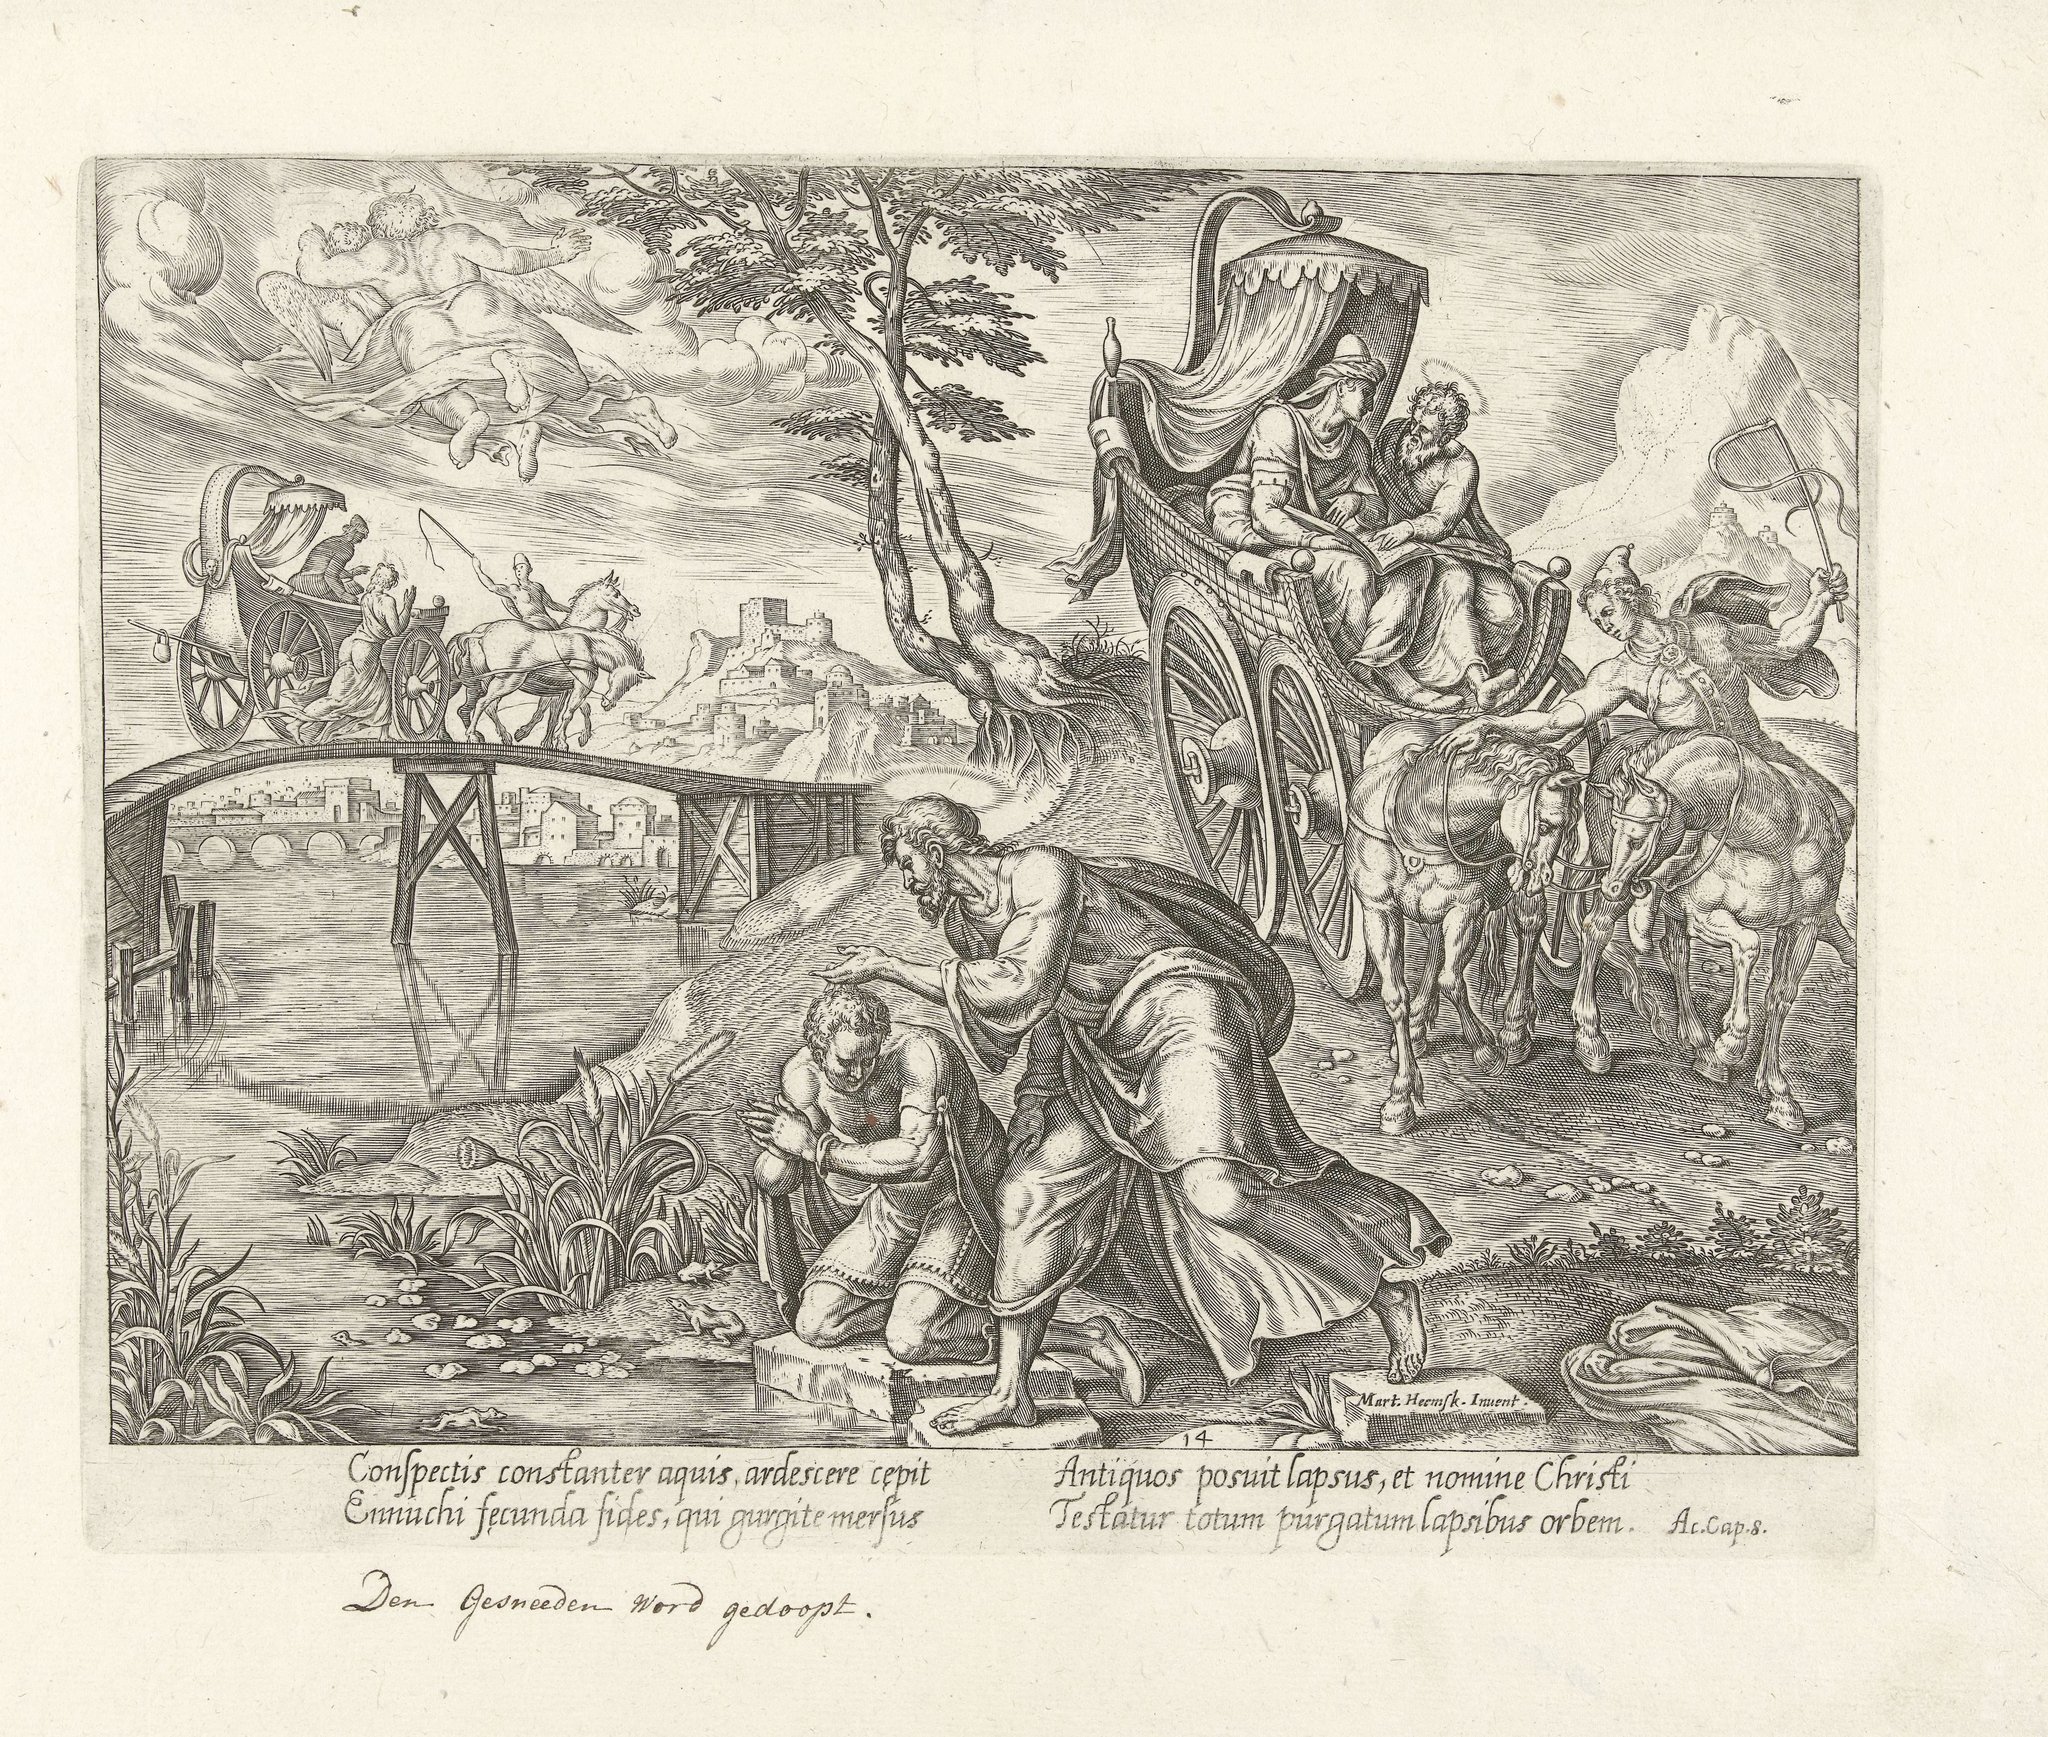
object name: print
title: Filippus en de eunuch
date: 1582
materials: paper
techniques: engraving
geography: haarlem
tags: philip baptizes the eunuch, translocation of philip (by an angel), philip explains the scripture to the eunuch, philip meets the eunuch, who is travelling in a chariot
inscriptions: collector's mark: Lugt 2228, caption: ‘Den gesneeden word gedoopt’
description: Filippus spreekt met de eunuch die hij ontmoet op de weg van Jeruzalem en Gaza. Als schatmeester van de koningin van Ethiopië rijdt de eunuch in een mooie koets. Filippus bekeert de eunuch tot het christendom en doopt hem in een rivier. Vervolgens wordt hij door een engel meegenomen. De prent heeft een Latijns onderschrift en maakt deel uit van een 34-delige serie met als onderwerp de Handelingen van de apostelen.